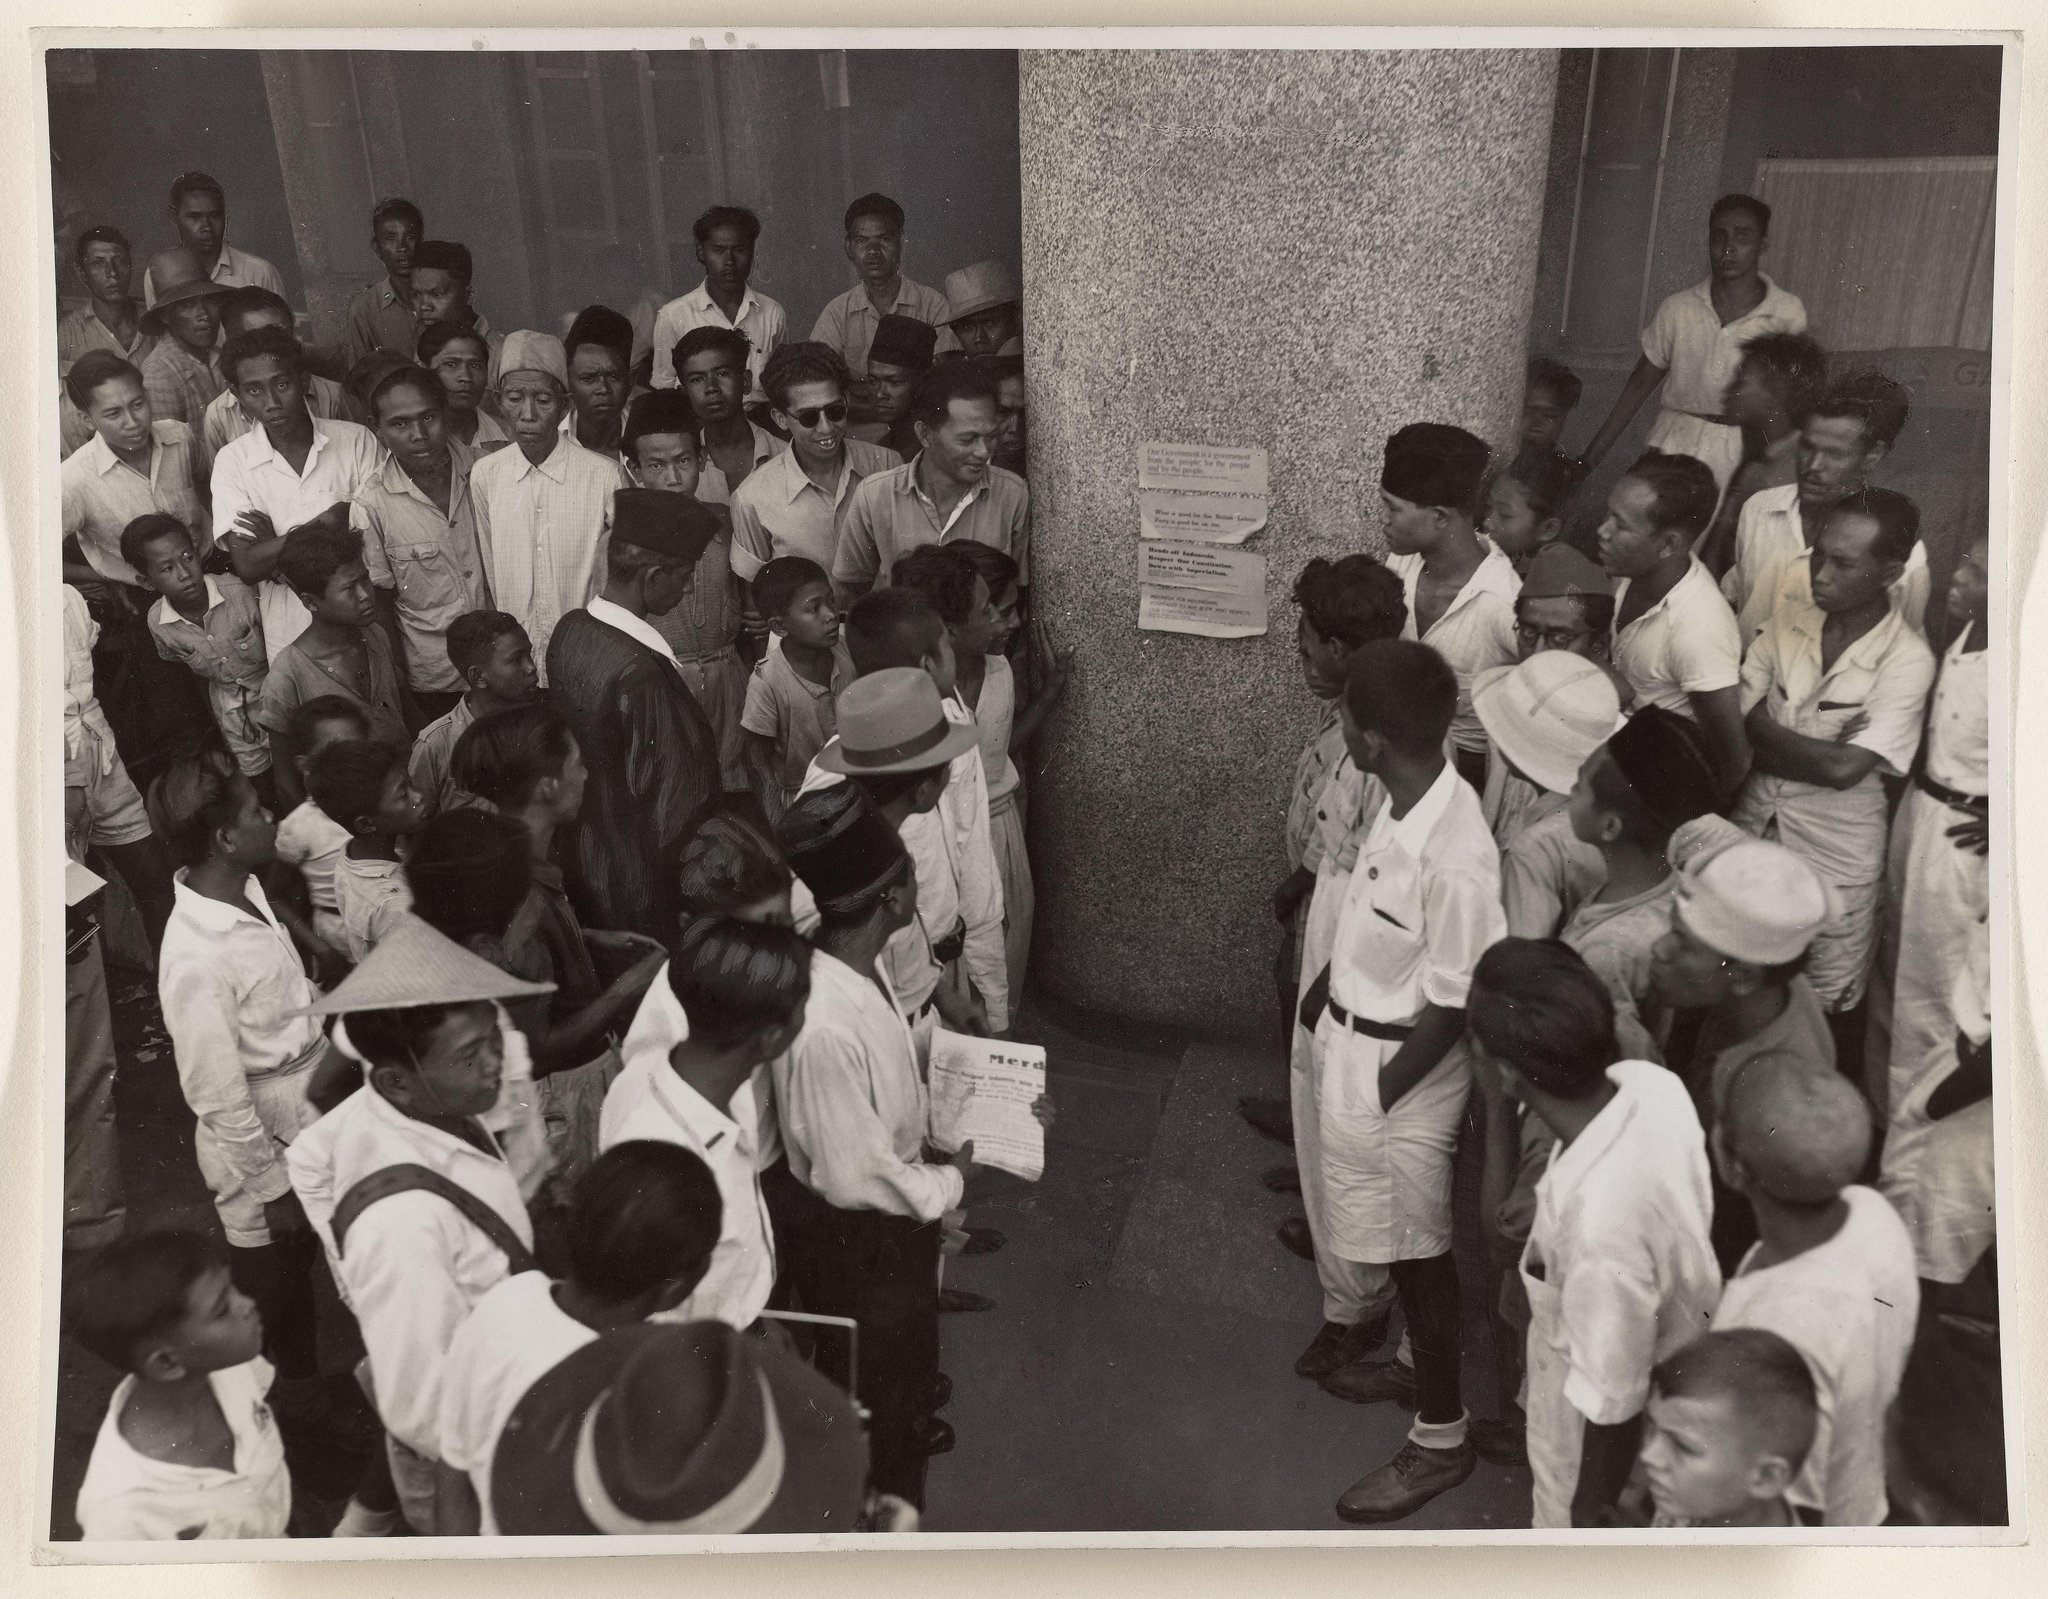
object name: documentary photograph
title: Straattoneeltje in verboden Batavia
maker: Anonymous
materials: photographic support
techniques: photography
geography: batavia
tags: batavia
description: Groep Indonesiërs in Batavia staat rondom een zuil een aantal aanplakbiljetten van de Partai Nasional Indonesia te lezen. Met onder andere de tekst: Our Government is a government from the people, ...the people and by the people.